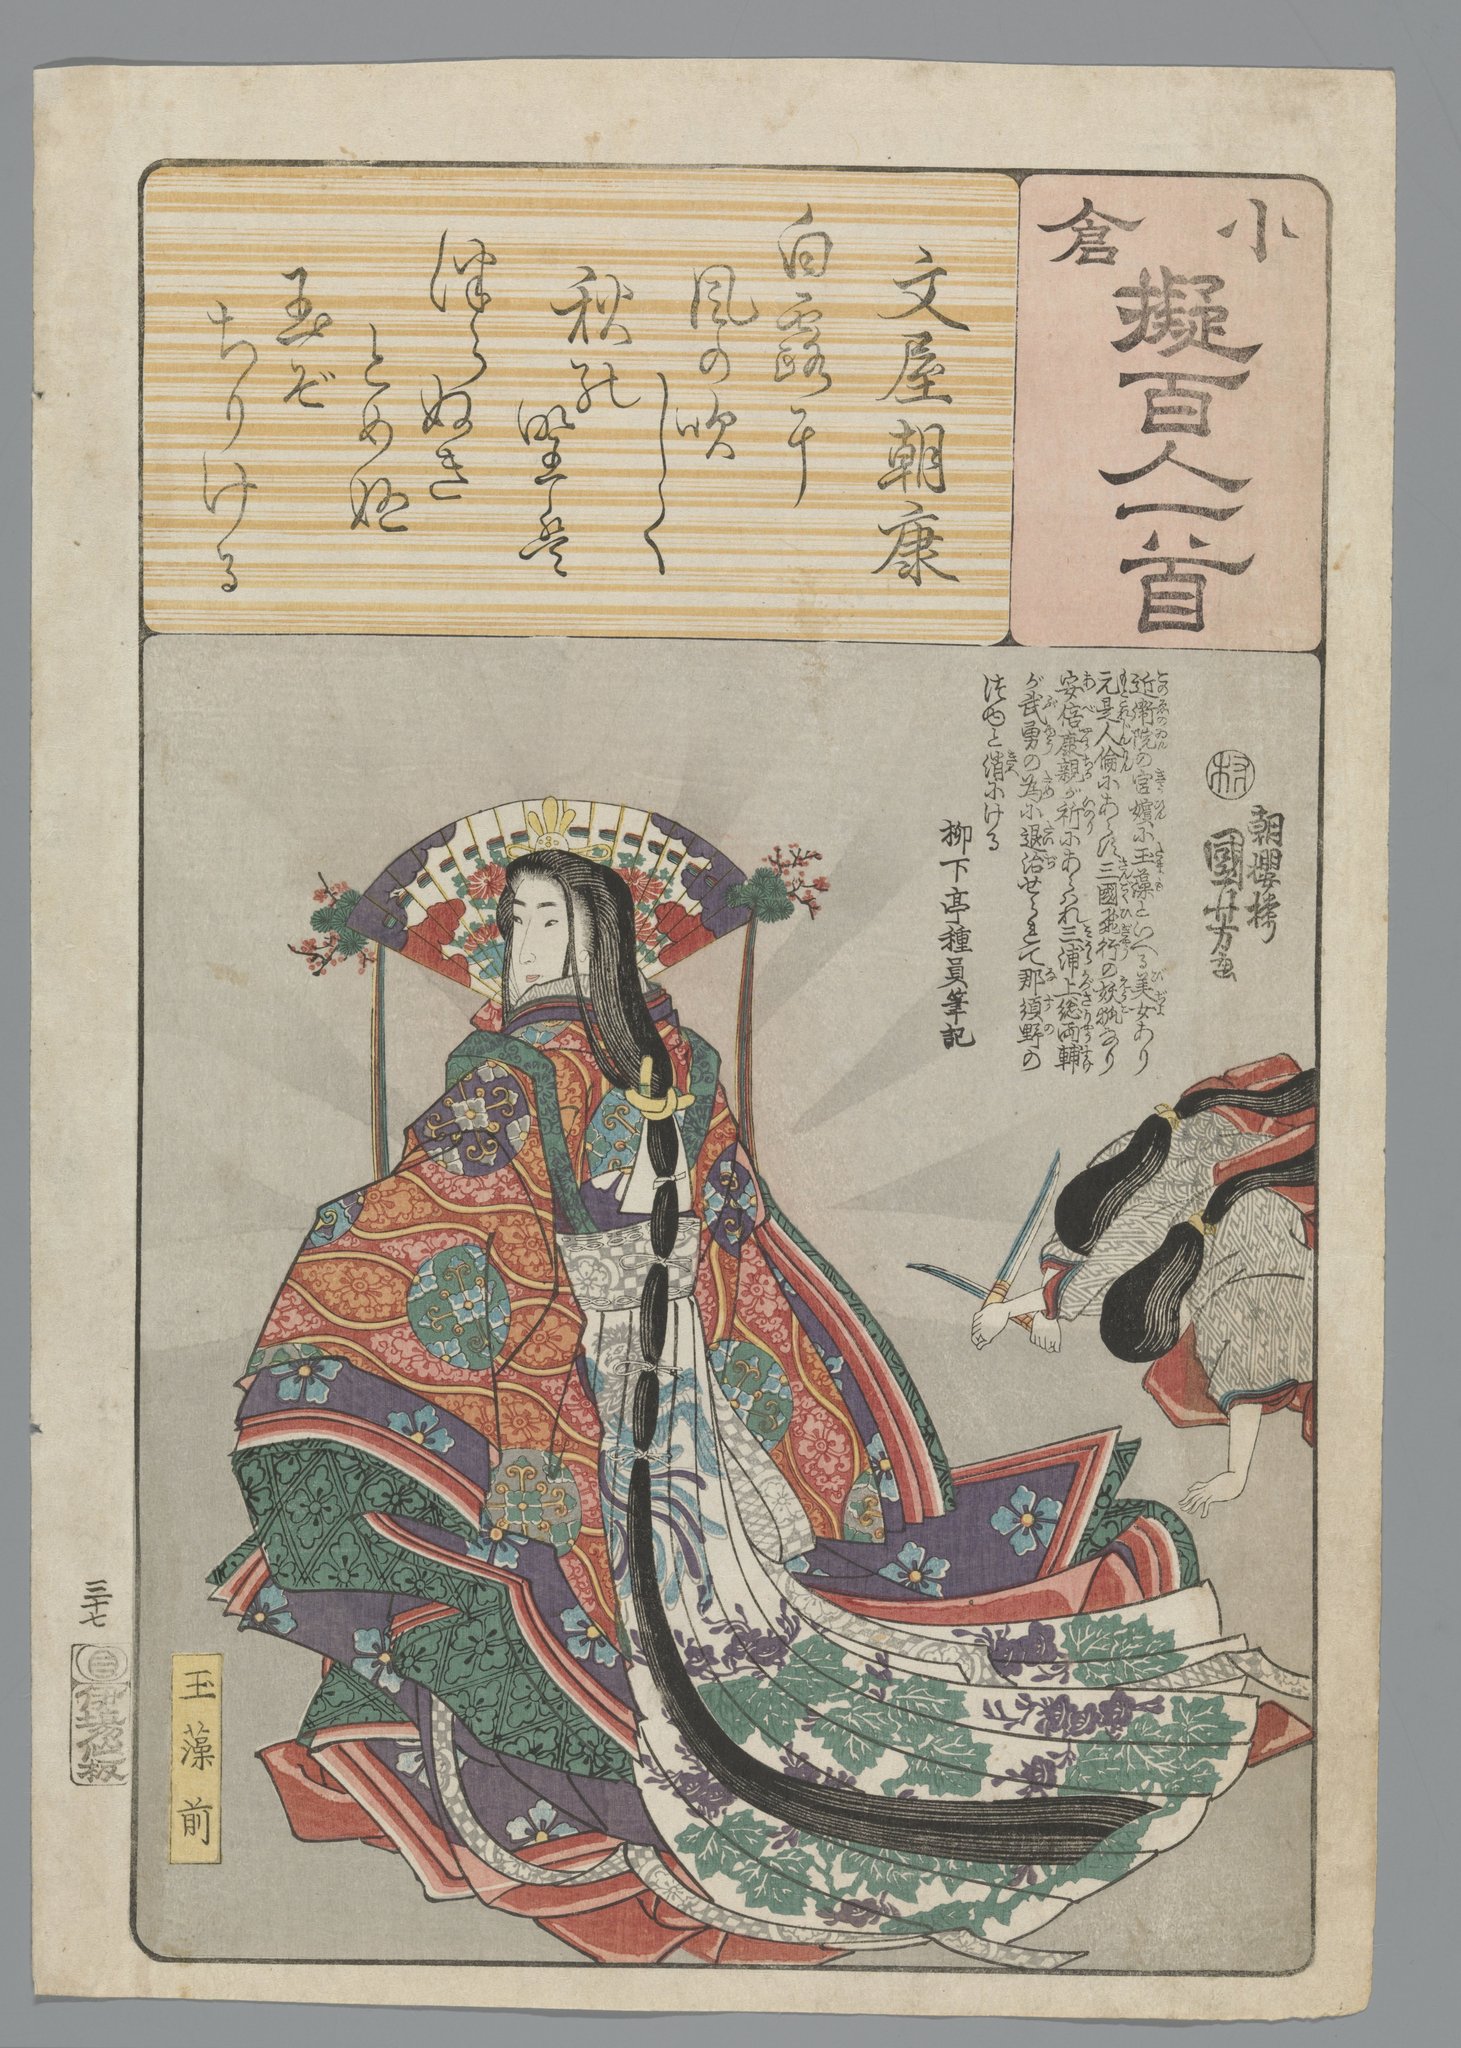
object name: print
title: Ogura Imitation of the One Hundred Poems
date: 1844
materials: paper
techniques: woodcut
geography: japan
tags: head bent forward; bowing - aa - female human figure, concubine, dignitary at court - bb - female dignitary: lady-in-waiting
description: Tamamo no Mae, de zeer intelligente en mooie concubine van keizer Toba. Op de achtergrond twee buigende hofdames met zwaarden Tamamo no Mae was in werkelijkheid een magische vos, die in Japanse legendes bekend staat als gedaanteverwisselaar. Scene uit een kabukitoneelstuk. Gedicht door Funya no Asayasu.